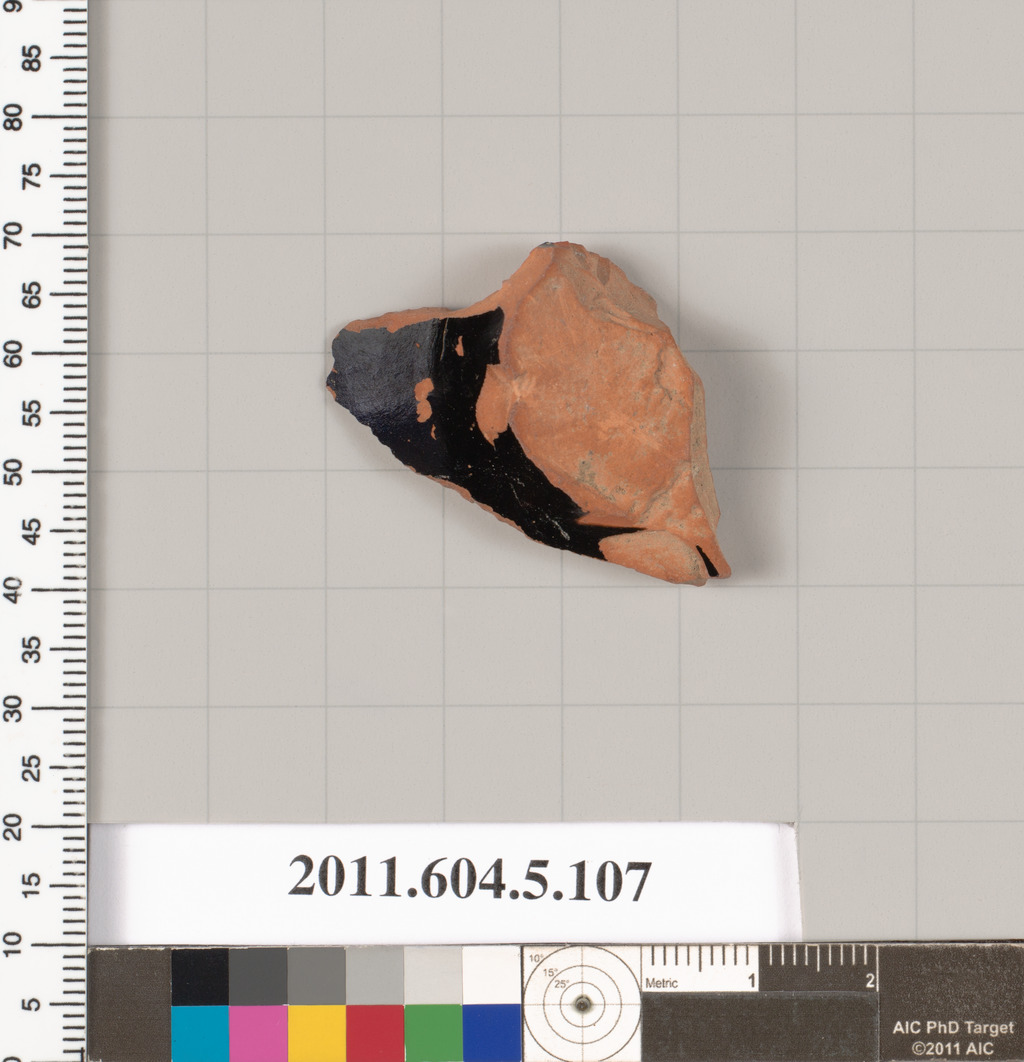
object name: kylix fragment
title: Terracotta fragment of a stemless kylix (drinking cup)?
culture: greek, attic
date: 470-450 BCE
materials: terracotta